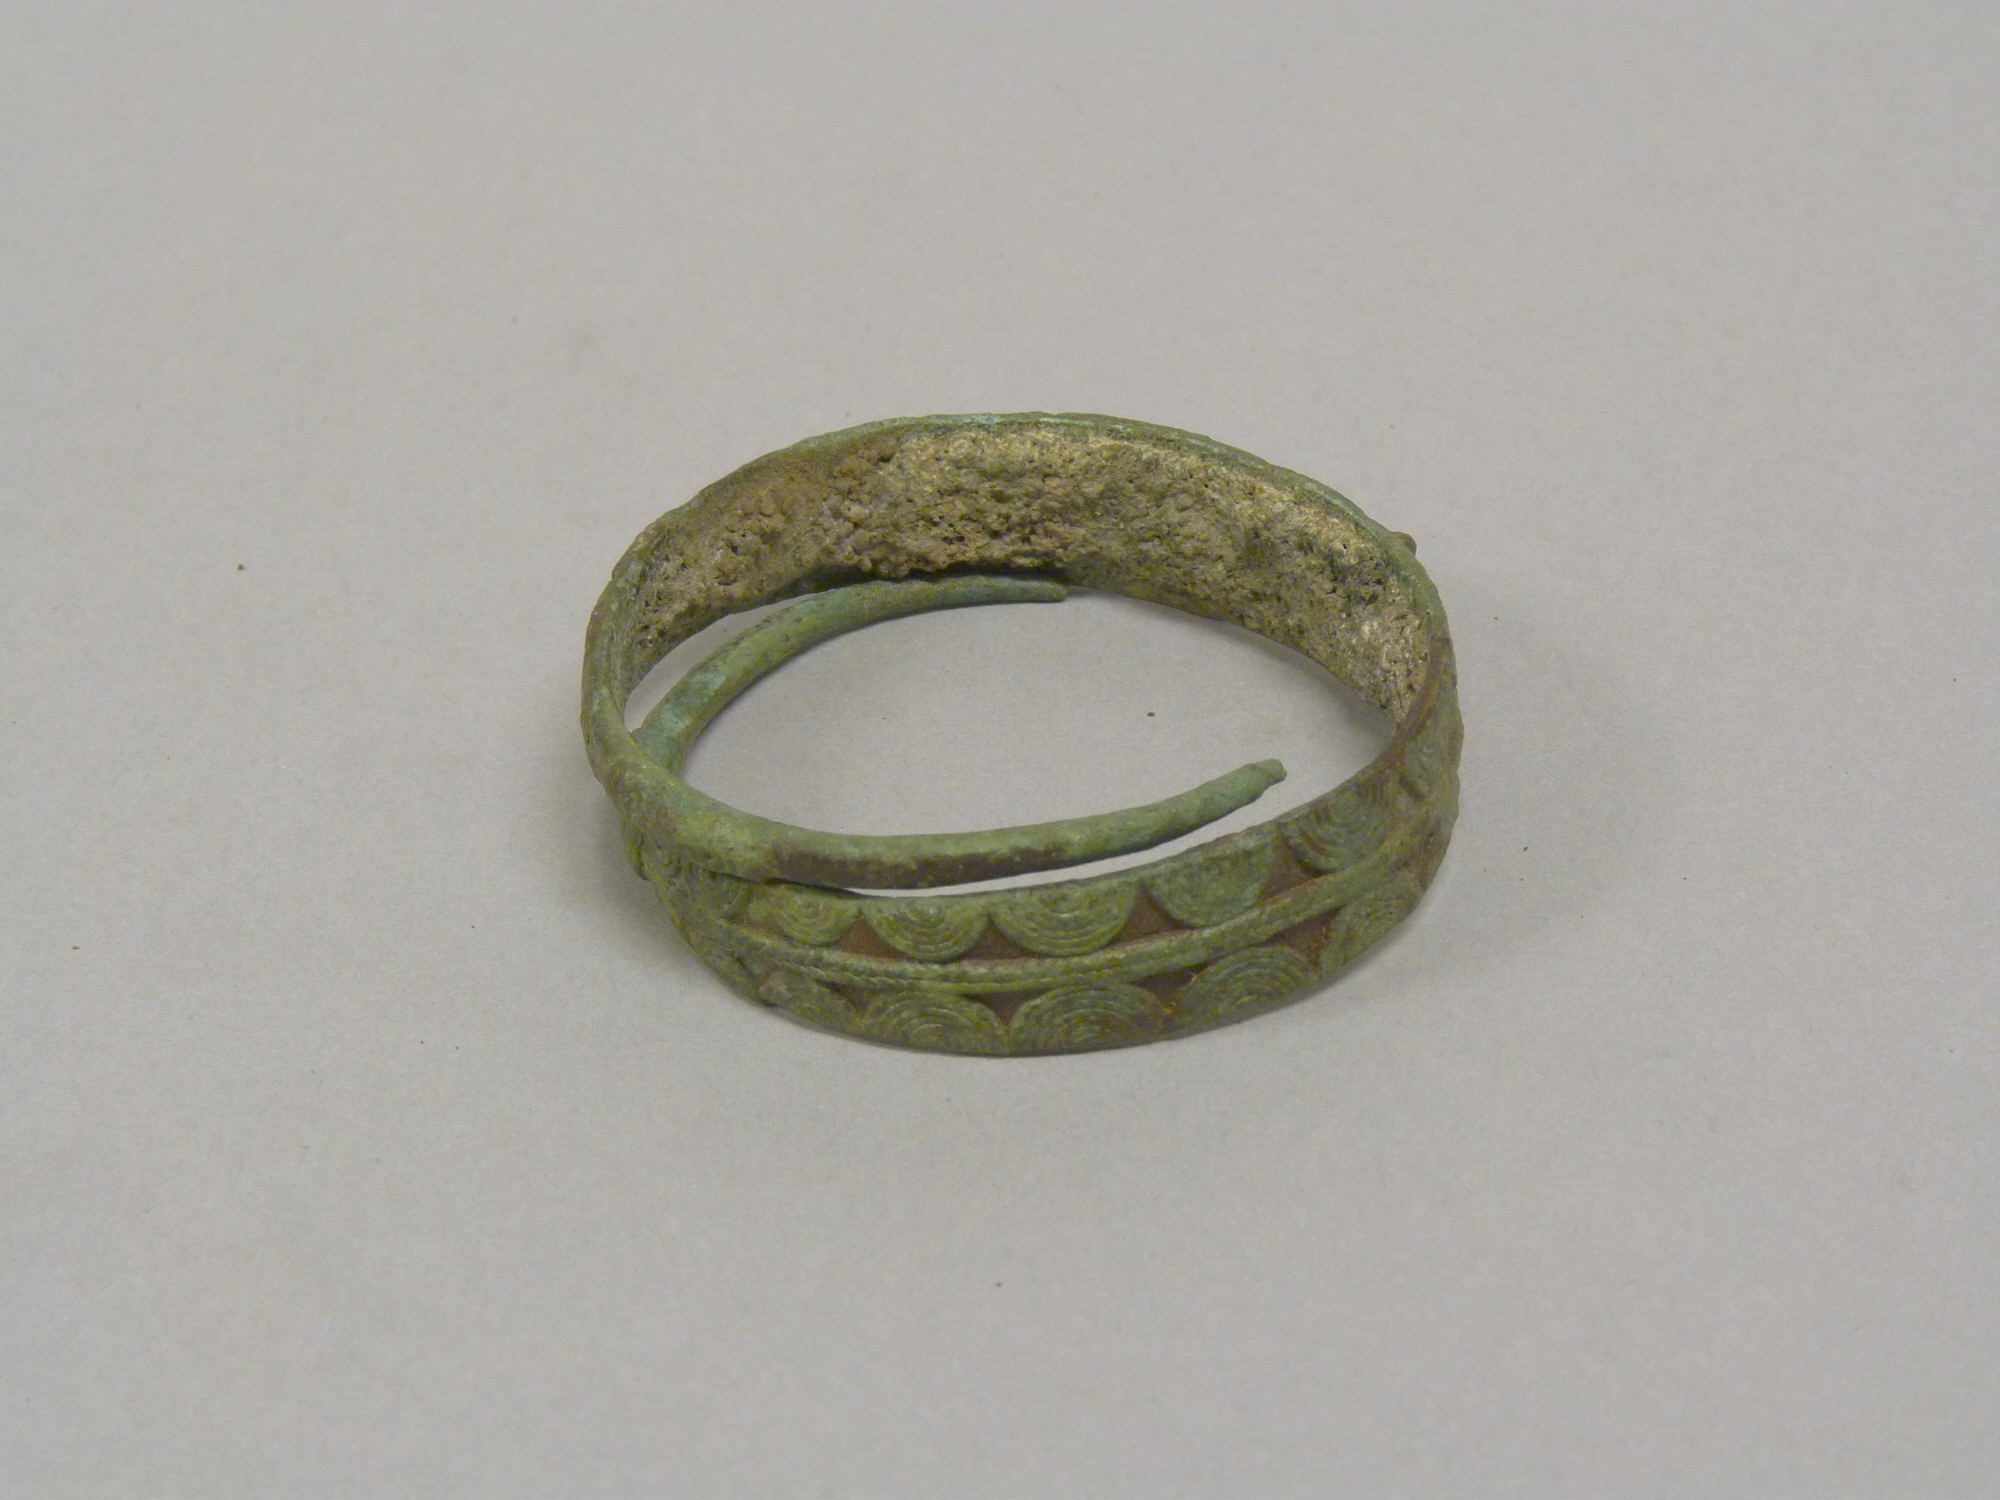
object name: bangle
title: Overlapping Bangle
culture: thai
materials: bronze